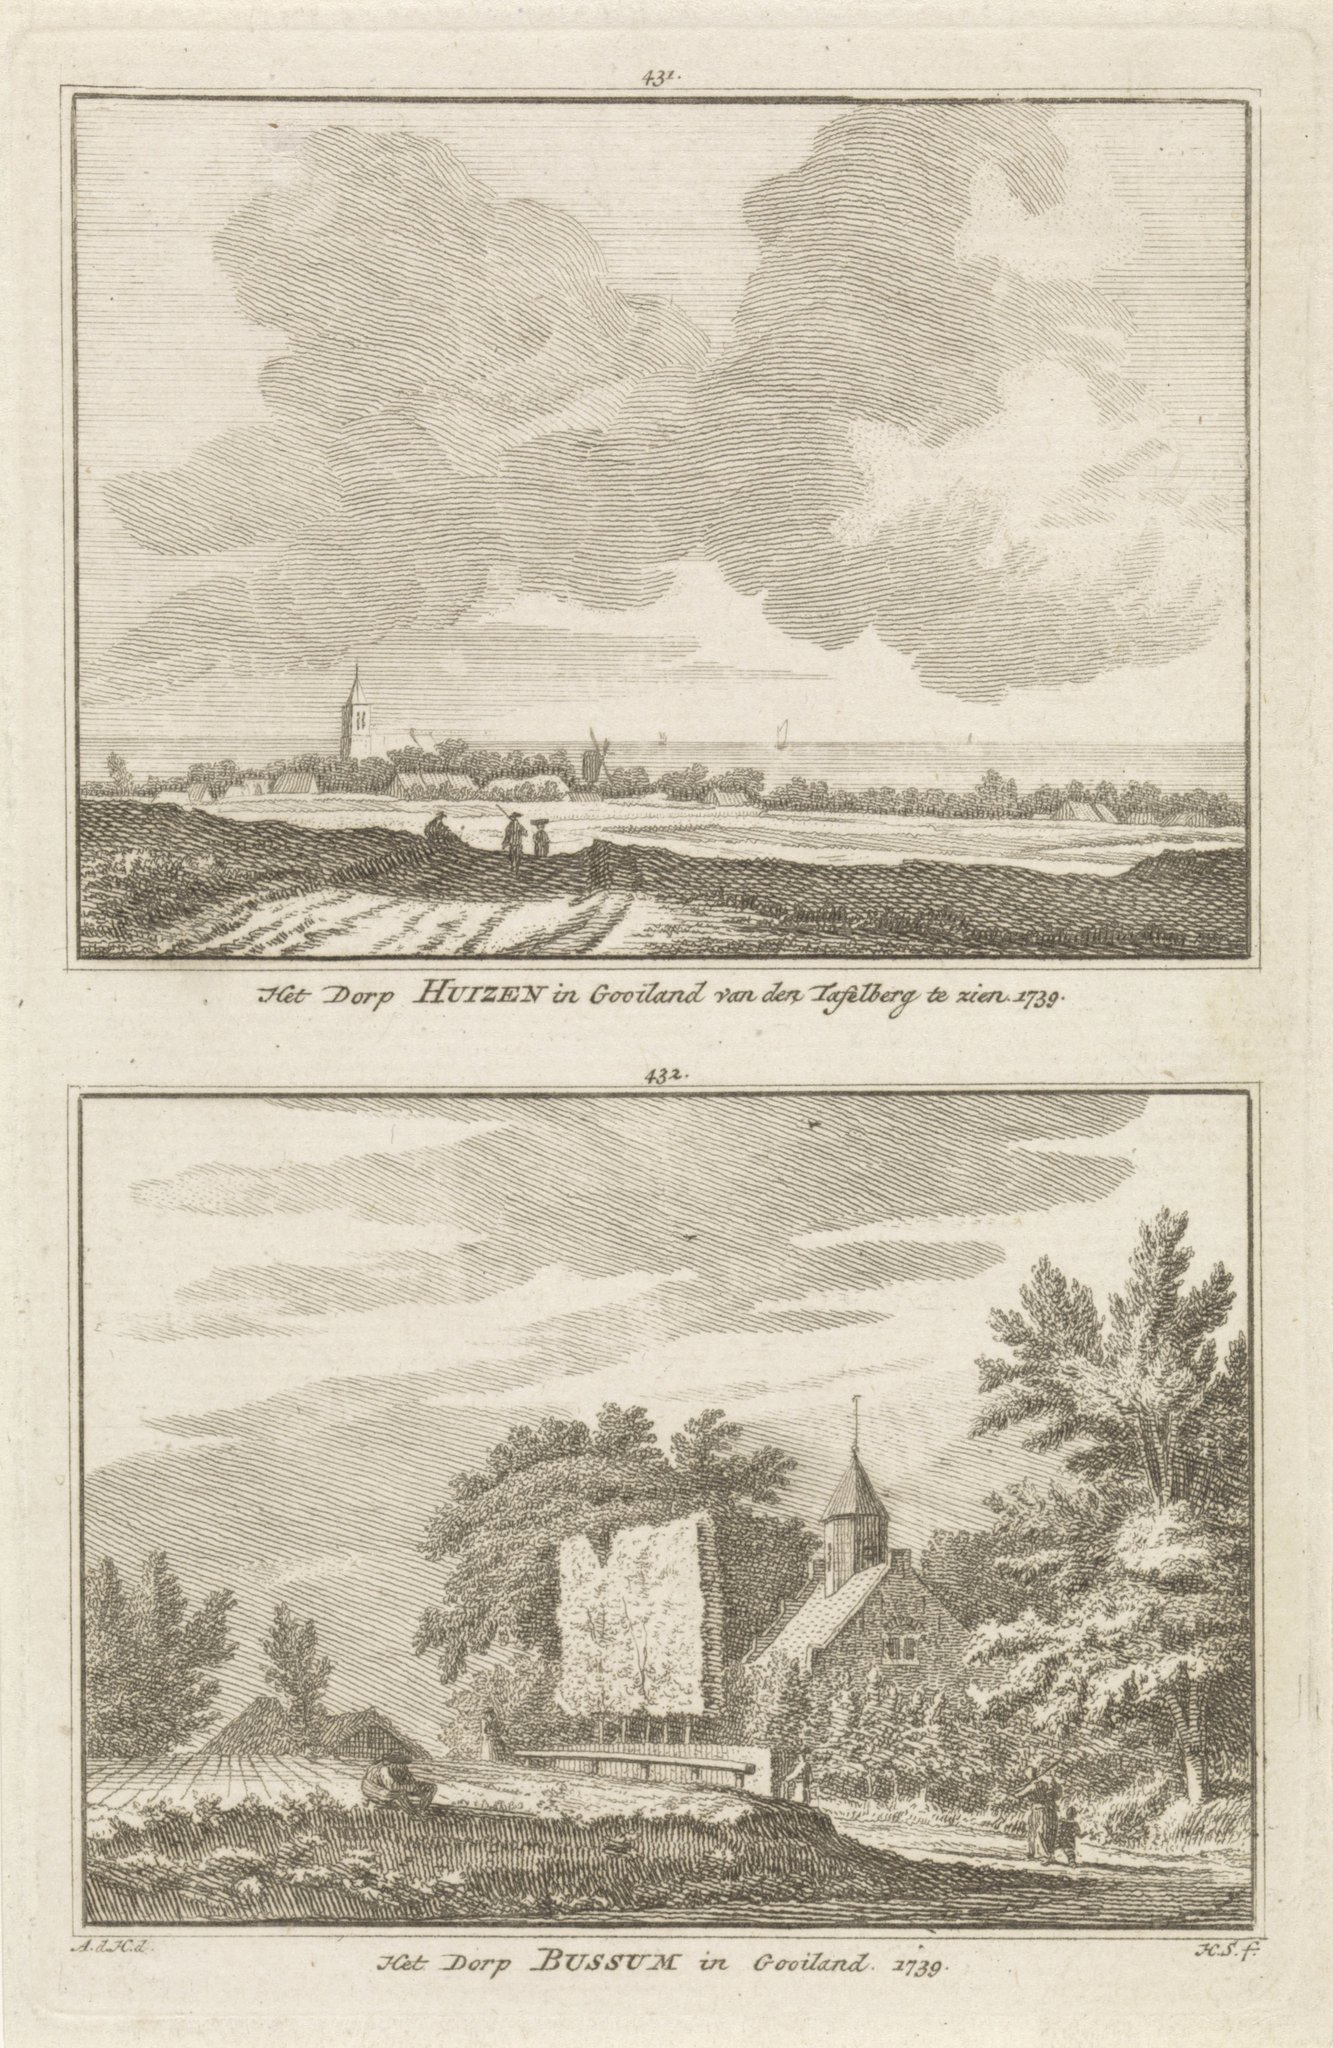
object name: print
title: Het dorp Huizen in Gooiland van den Tafelberg te zien 1739/ Het Dorp Bussum in Gooiland 1739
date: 1757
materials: paper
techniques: etching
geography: haarlem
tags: prospect of village, silhouette of village, church (exterior), public road in village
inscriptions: collector's mark: Lugt 2228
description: Prent gebruikt in: Het verheerlykt Nederland of kabinet van hedendaagsche gezigten van steden, dorpen, sloten ... en andere voornaame stad- en landgebouwen, in en omtrent alle de byzondere Vereenigde Nederlandsche Provinciën : gedurende de laatste jaaren door vermaarden kunsttekenaren na het leven getekent en ... in 't koper gebragt ... dienende tot opheldering der beschryvinge van den Tegenwoordigen Staat der Vereenigde Nederlanden. Deel VI, 1757. Amsterdam: Isaac Tirion, 1745-1774.